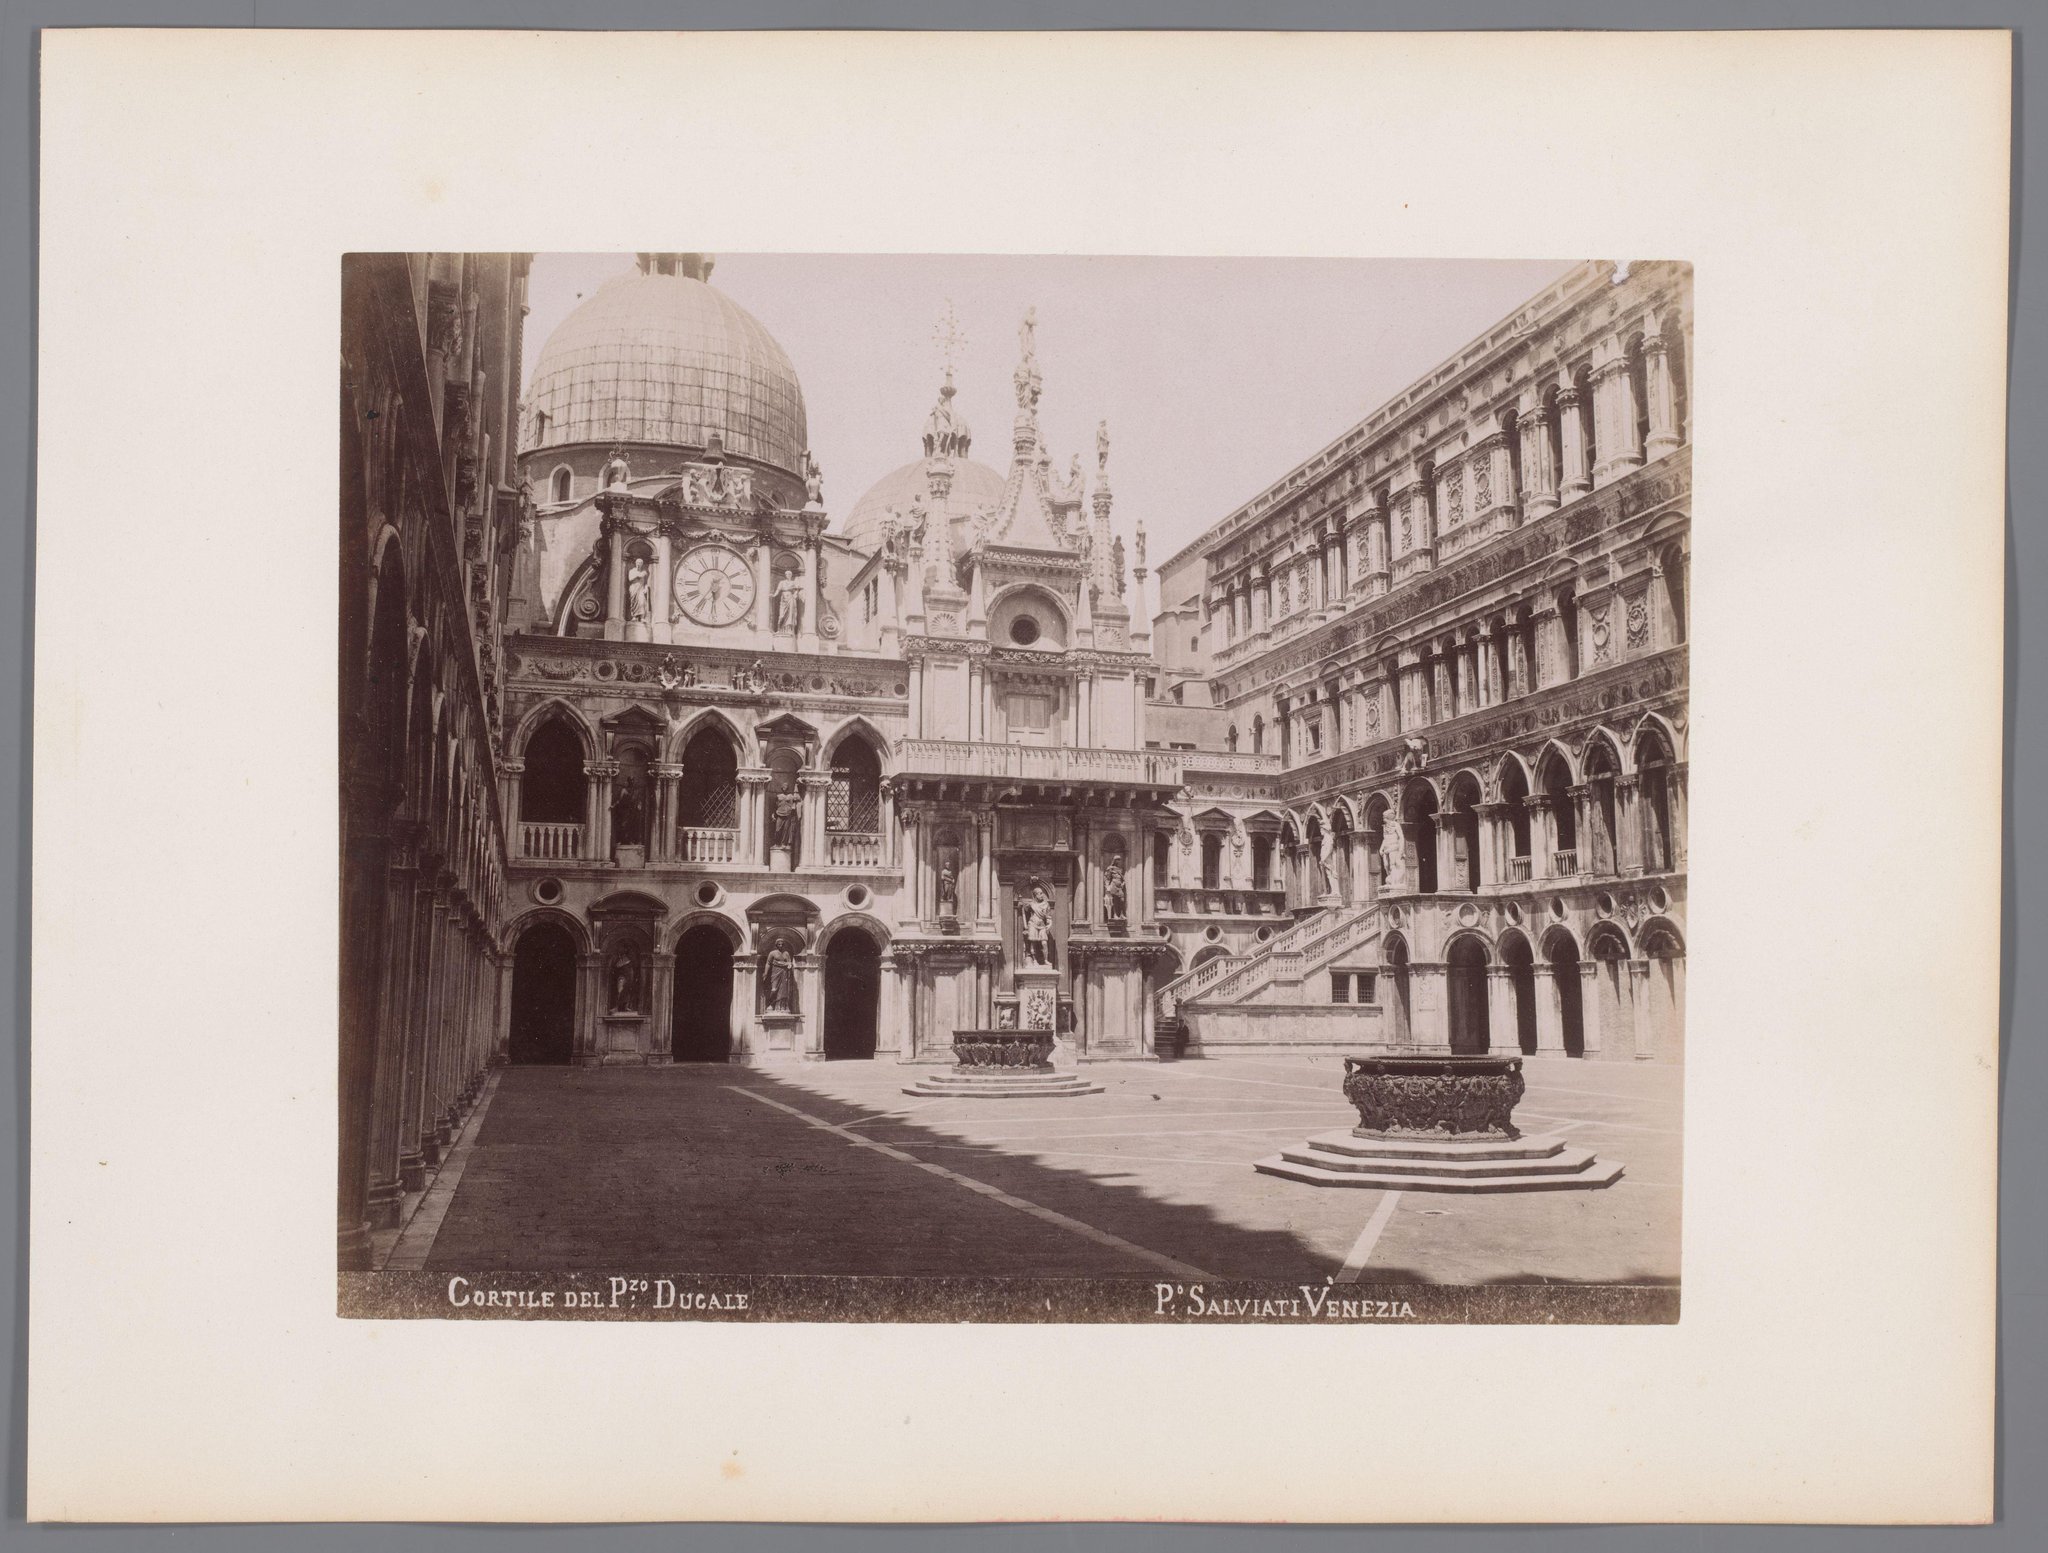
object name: photograph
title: Cortile del P:zo Ducale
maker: paolo salviati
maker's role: fotograaf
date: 1860-1870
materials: cardboard, paper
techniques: albumen print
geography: venice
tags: palace, inner court of palace or 'hôtel'